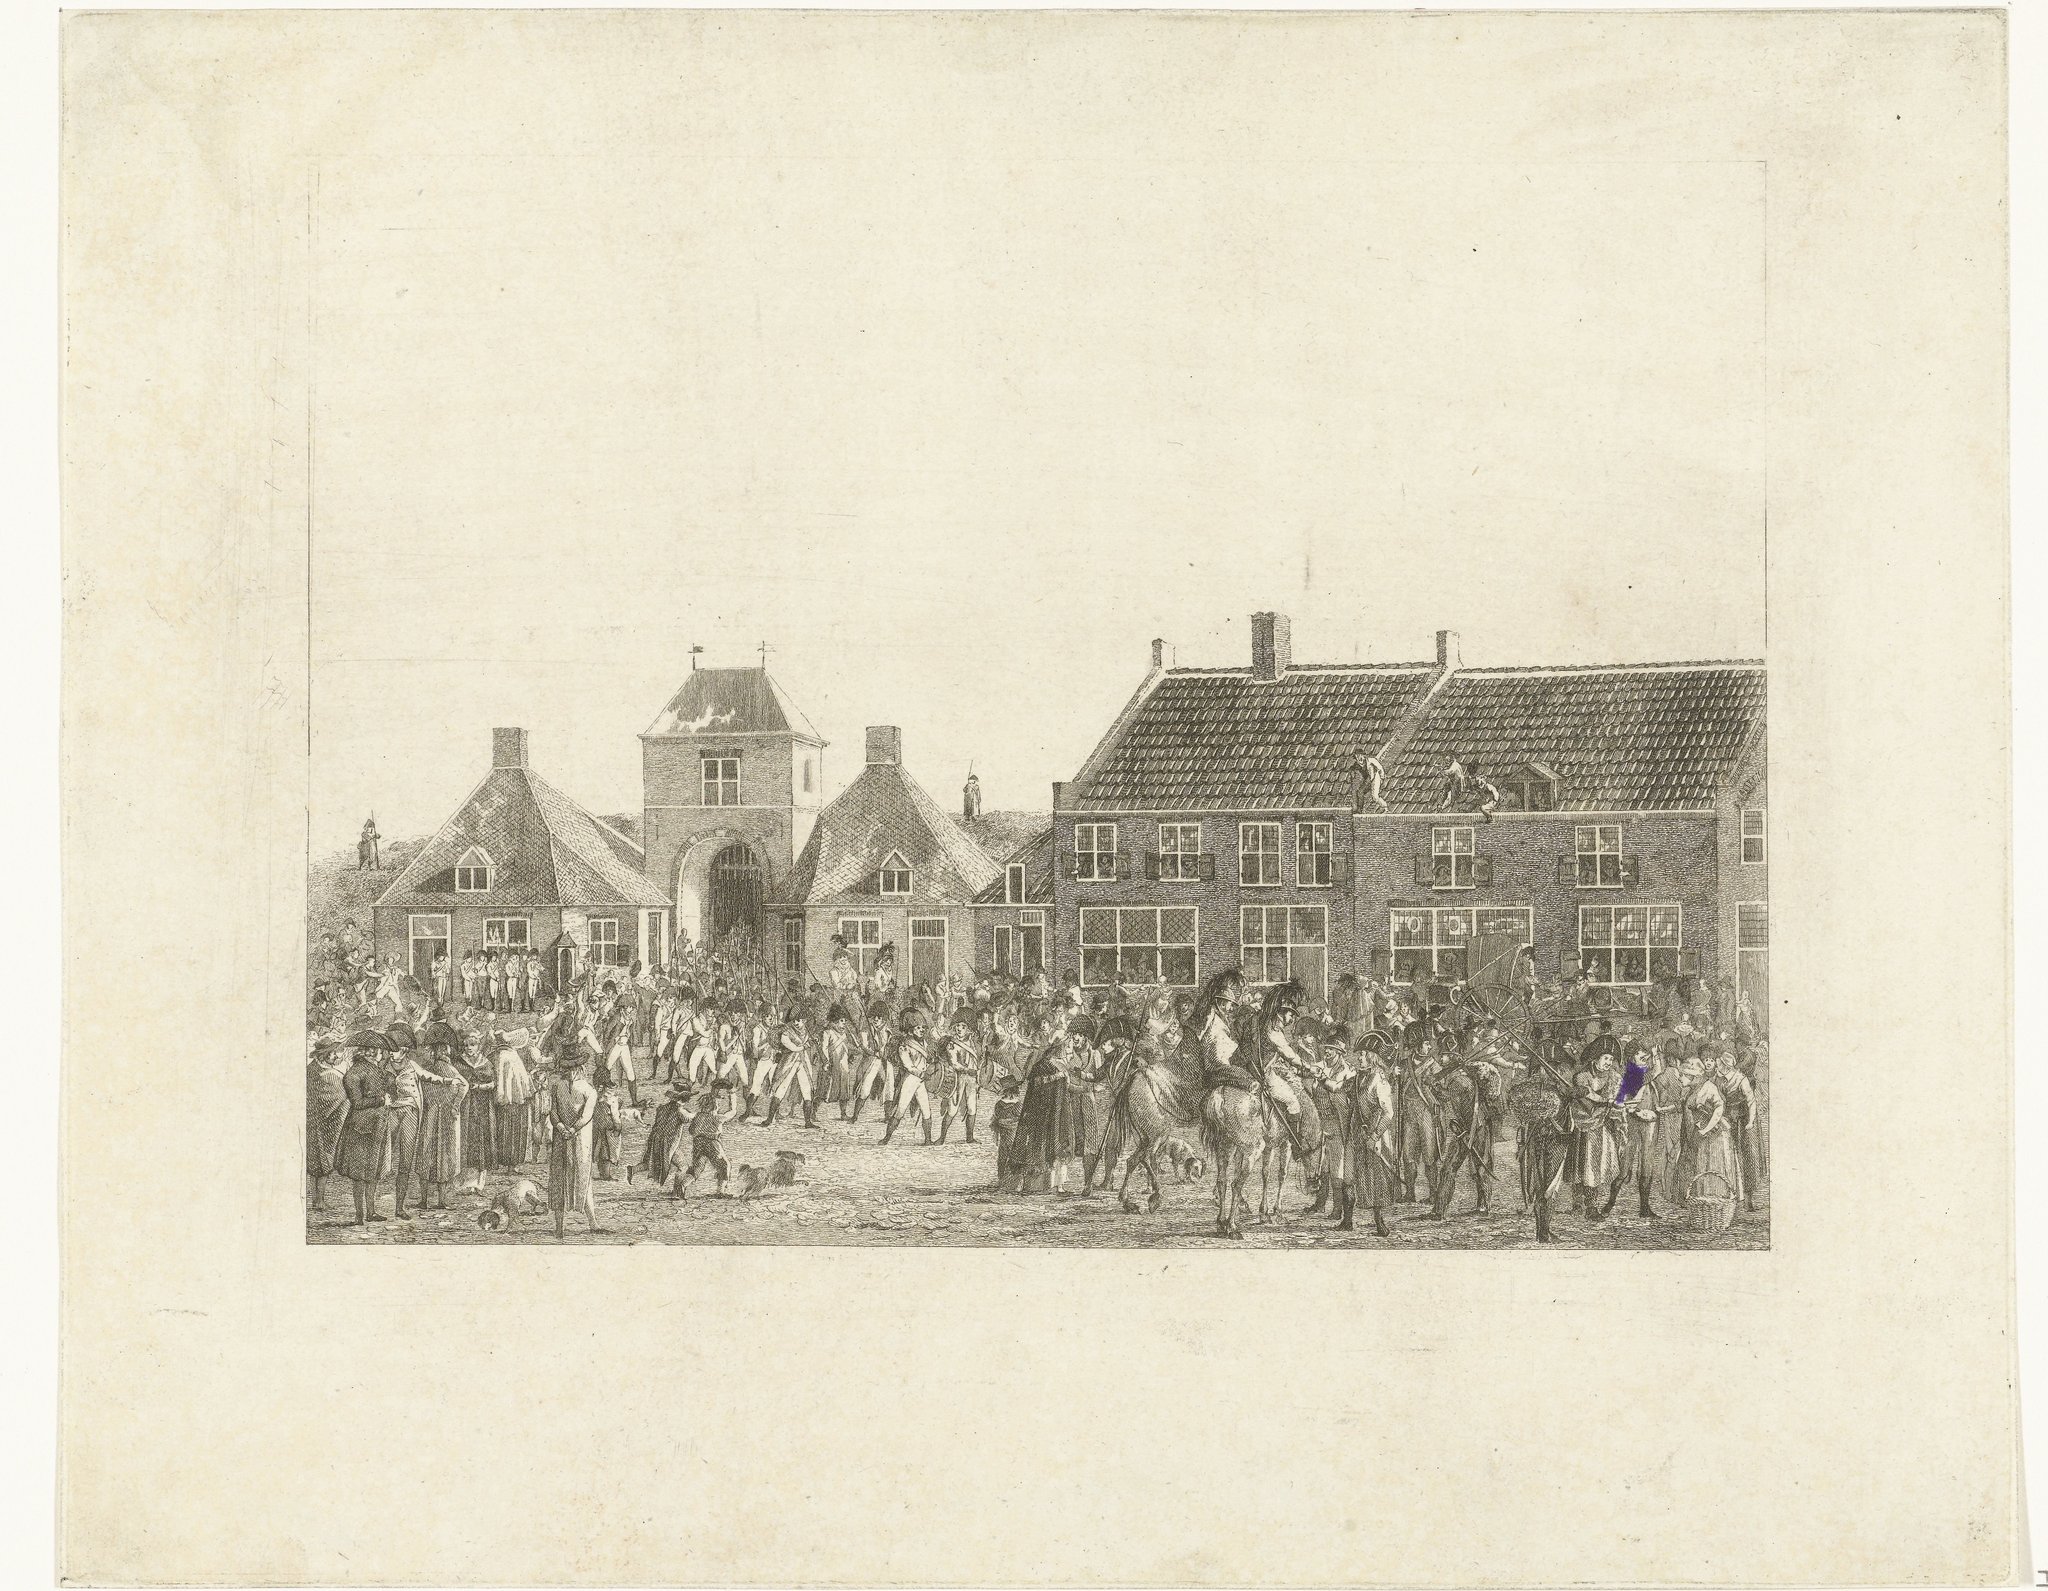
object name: print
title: Franse troepen trekken Breda binnen, 1793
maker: joannes bemme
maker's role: print maker, printer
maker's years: 1775-1841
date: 1800-1841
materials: paper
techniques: etching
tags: occupation ~ war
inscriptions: collector's mark: Lugt 2228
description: Franse troepen trekken door de Haagpoort de stad binnen. Op een plein worden ze door de bevolking ontvangen. Rechts bieden vrouwen de soldaten iets te eten aan.